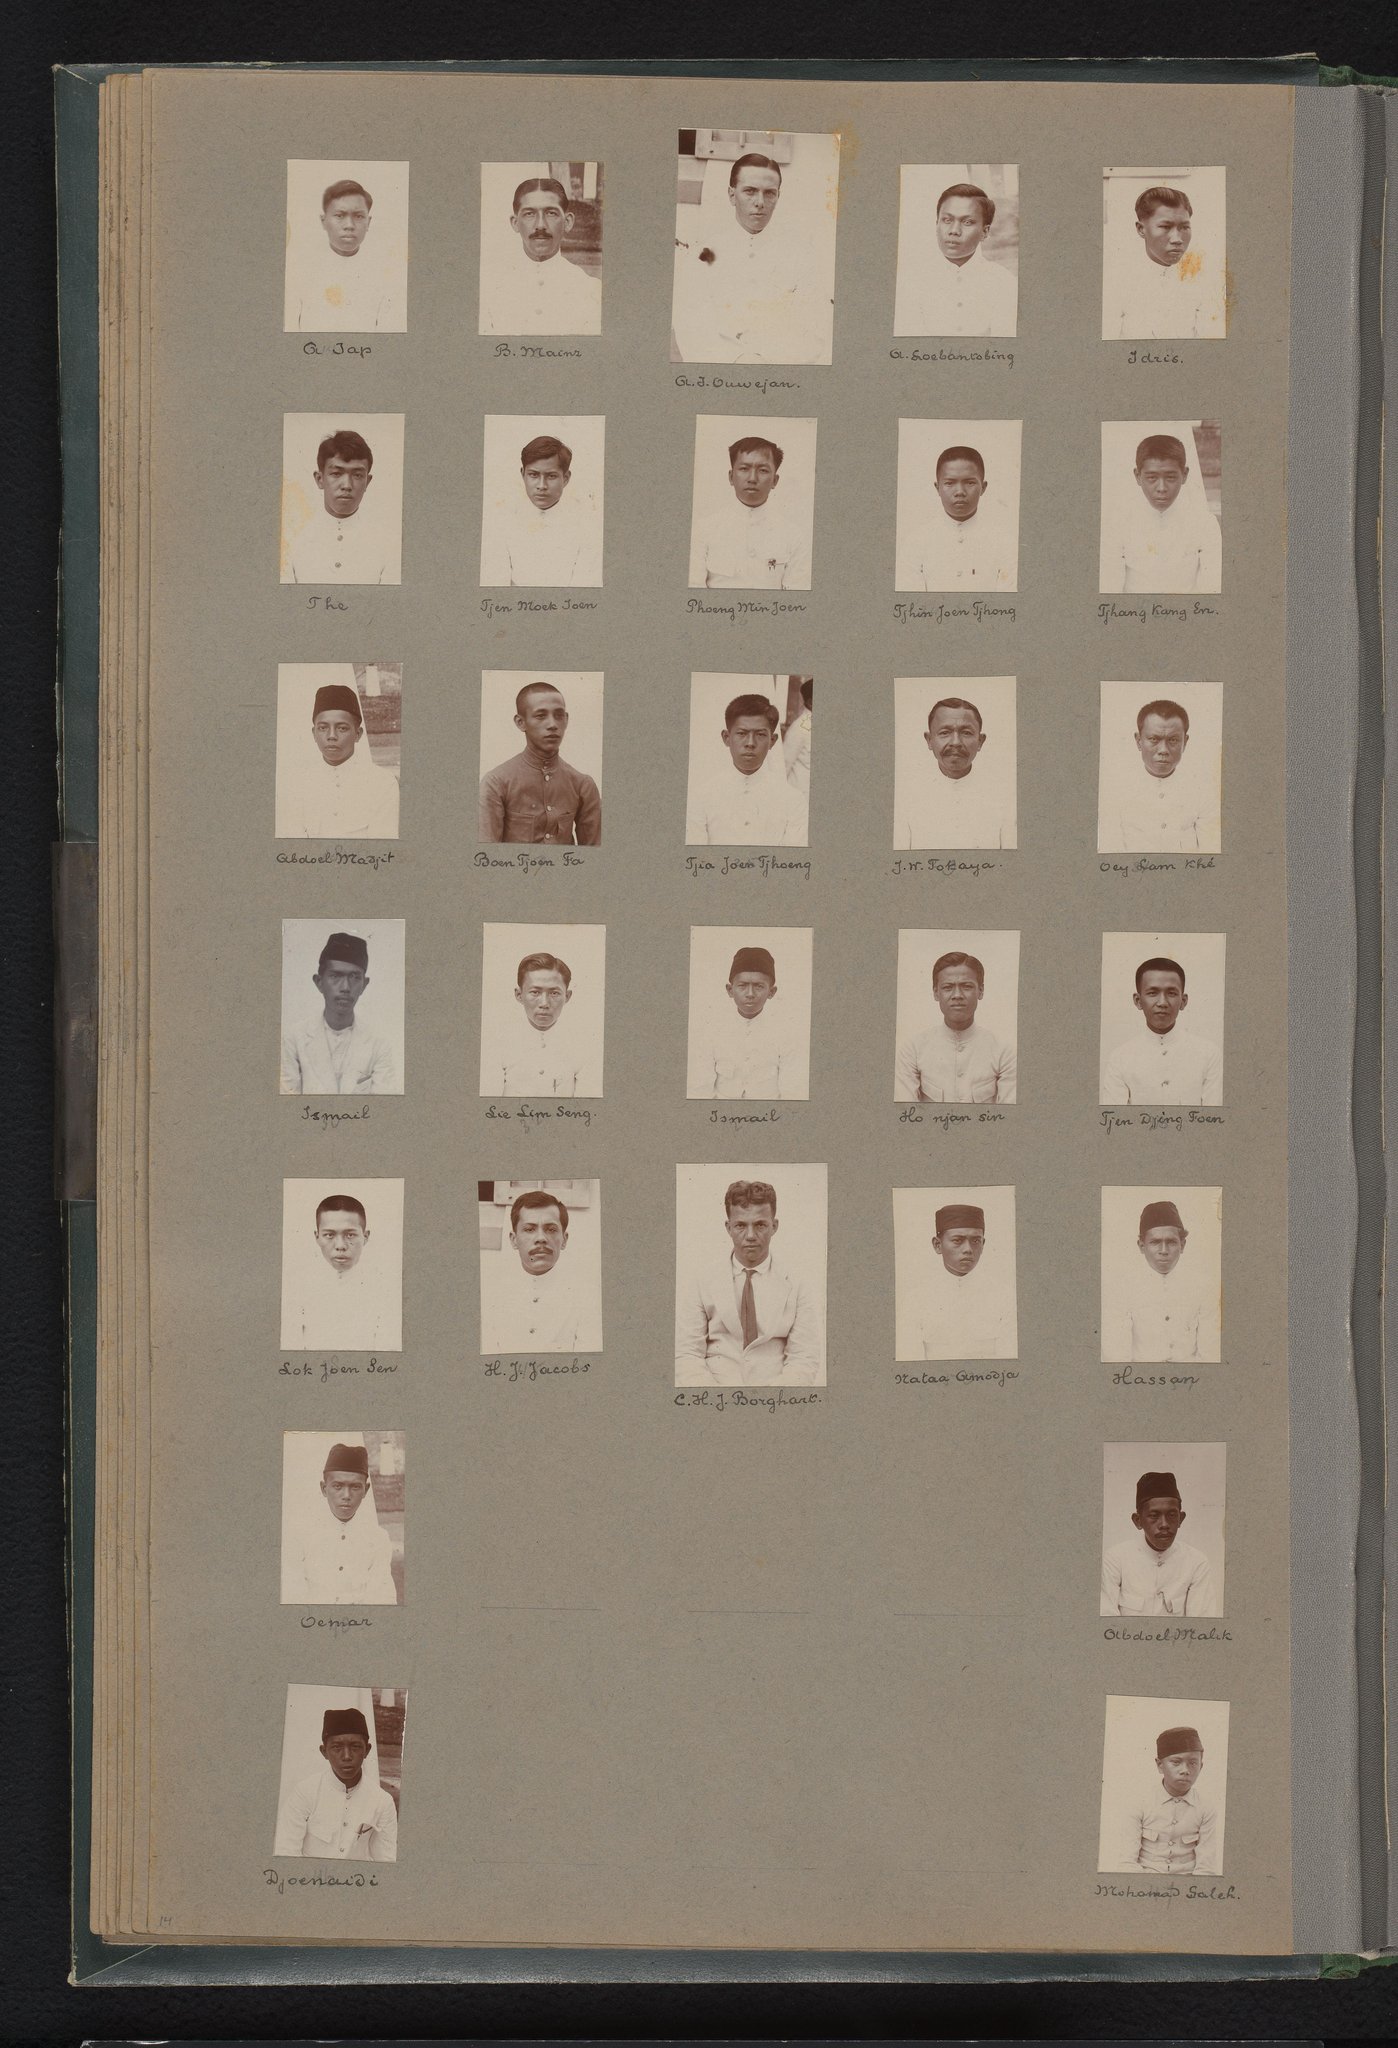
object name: photograph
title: Pasfoto's personeel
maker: Anonymous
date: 1914-1919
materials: cardboard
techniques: gelatin silver print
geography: bangka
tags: robert julius boers, colonial system, mining, historical persons, industries ~ metal (+ men (labourers))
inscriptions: inscription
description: Albumblad met 29 kleine pasfoto's van personeel werkzaam bij het hoofdbureau van de Banka-tinwinning te Muntok. Portretten van Indonesische mannen en enkele Nederlanders, zonder aanduiding van functie. Onder de foto's de naam van de geportretteerde. Onderdeel van het fotoalbum aangeboden aan Robert Julius Boers bij zijn vertrek naar Nederland in 1919 door het personeel van de Banka-tinwinning.